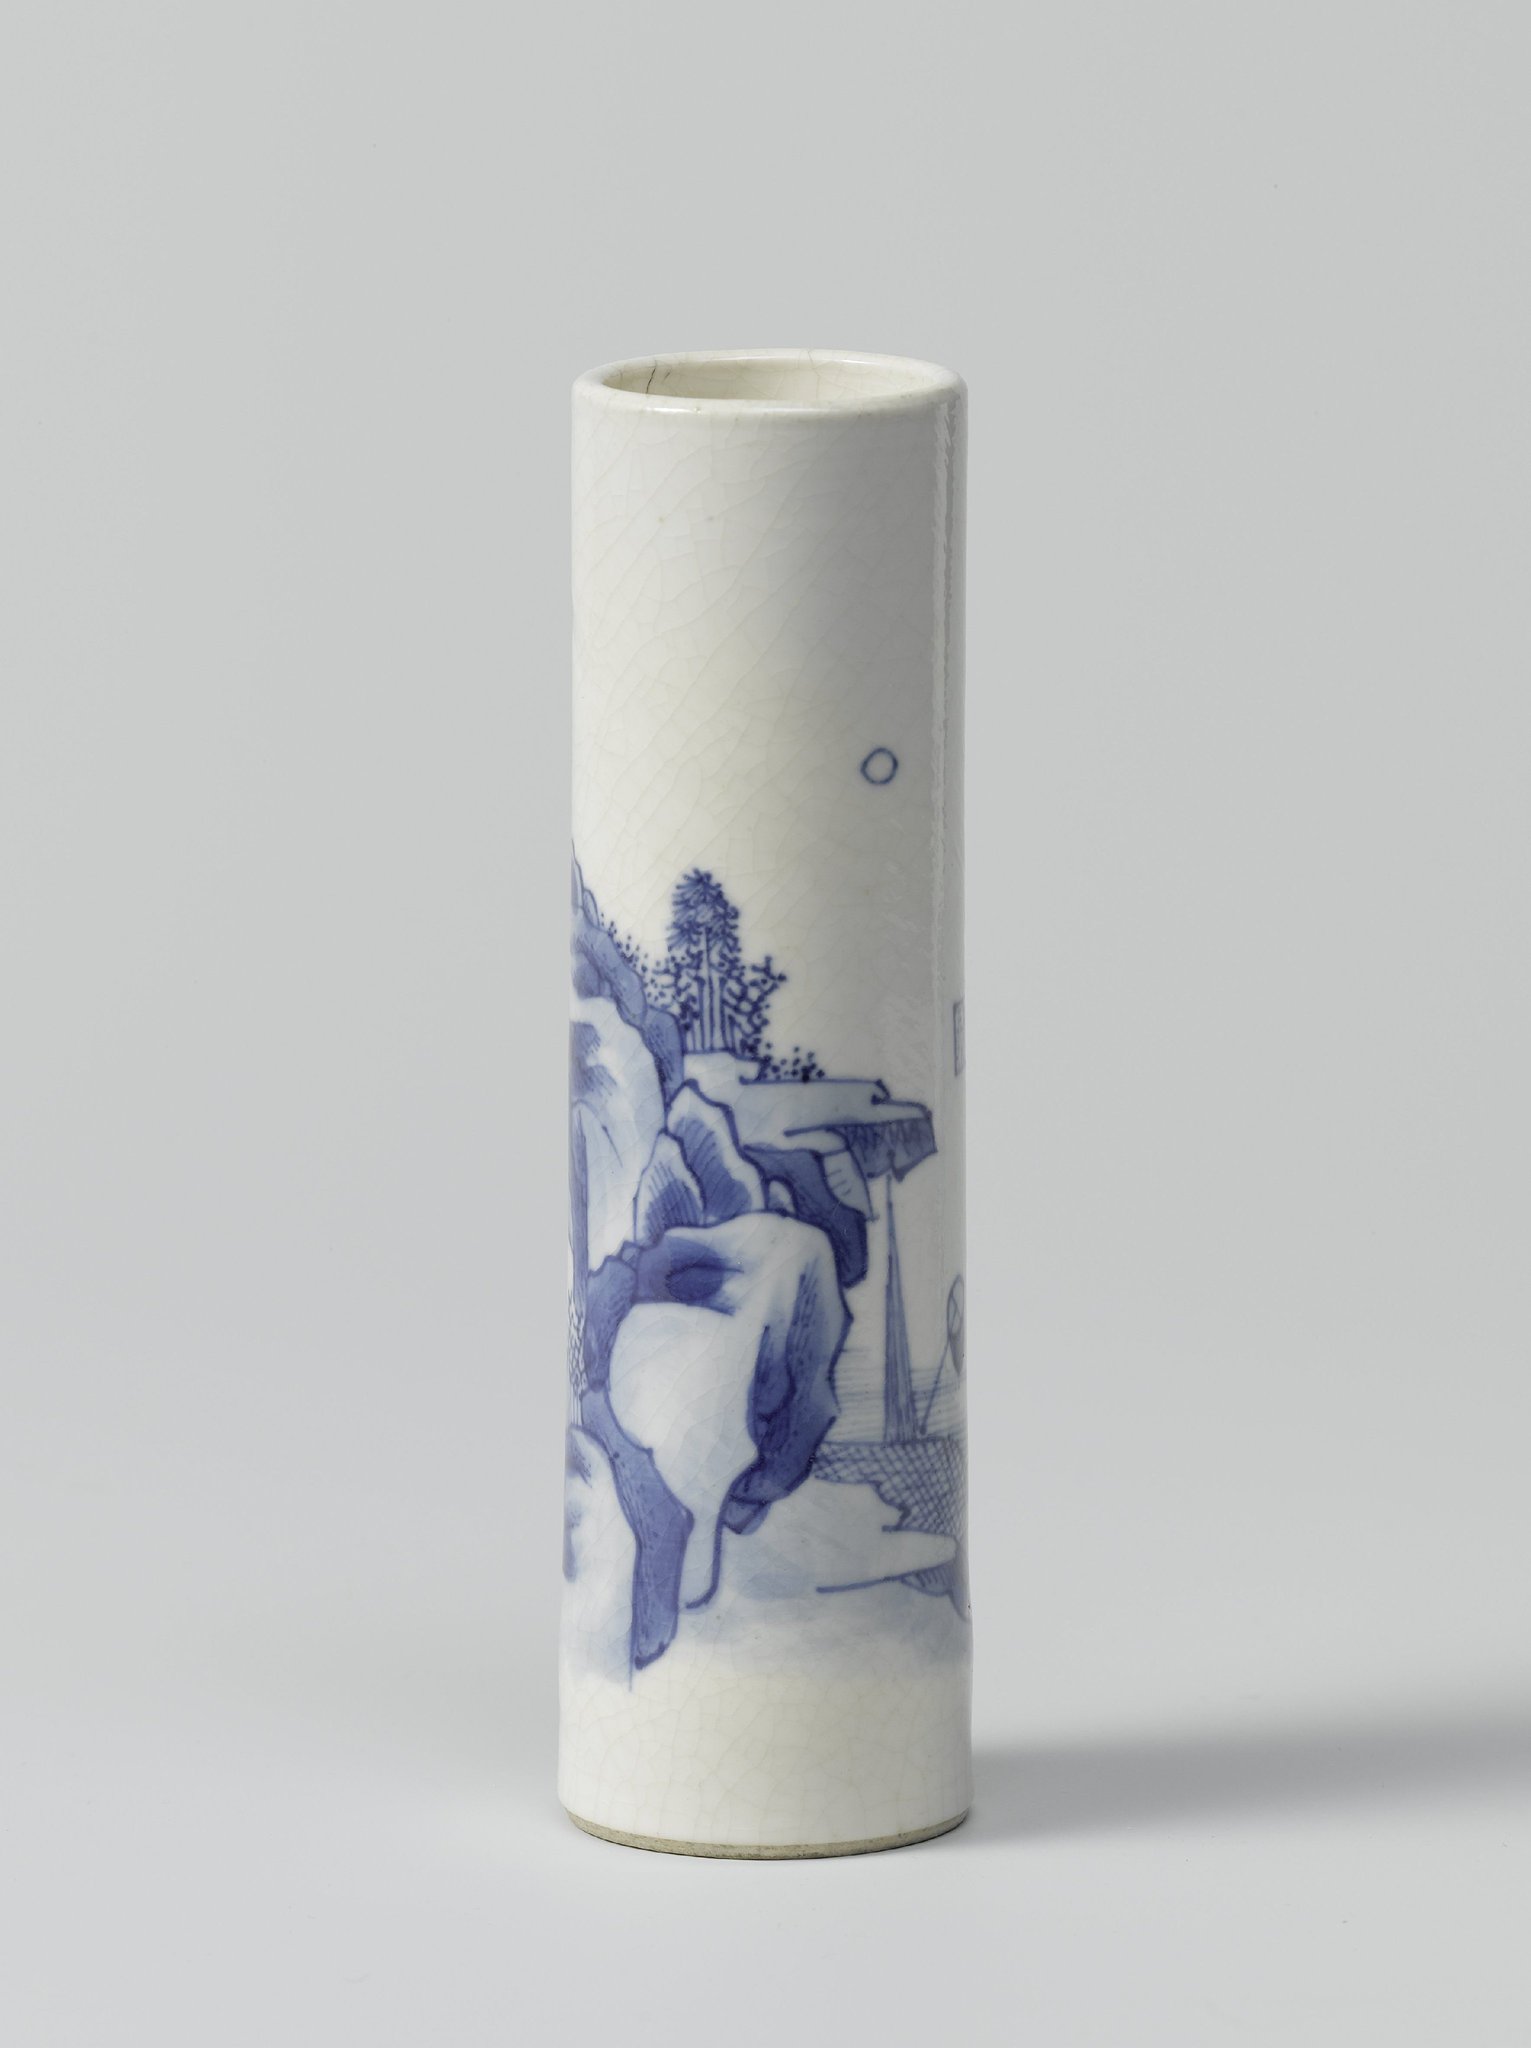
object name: penselenstandaard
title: Brush Pot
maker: Anonymous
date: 1700-1724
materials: cobalt, glaze, paint, porcelain, soft paste porcelain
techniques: firing, turning, vitrification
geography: china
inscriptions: inscription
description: Penselenstandaard van soft-paste porselein (pâte tendre), beschilderd in onderglazuur blauw. Op de wand een voorstelling van een vissersboot in een rivierlandschap. Boven de voorstelling een opschrift in karakters met 'water in duizend rivieren, in duizend rivieren schijnt de maan; tienduizend mijlen zonder wolken, tienduizend mijlen hemel'. Blauw-wit.